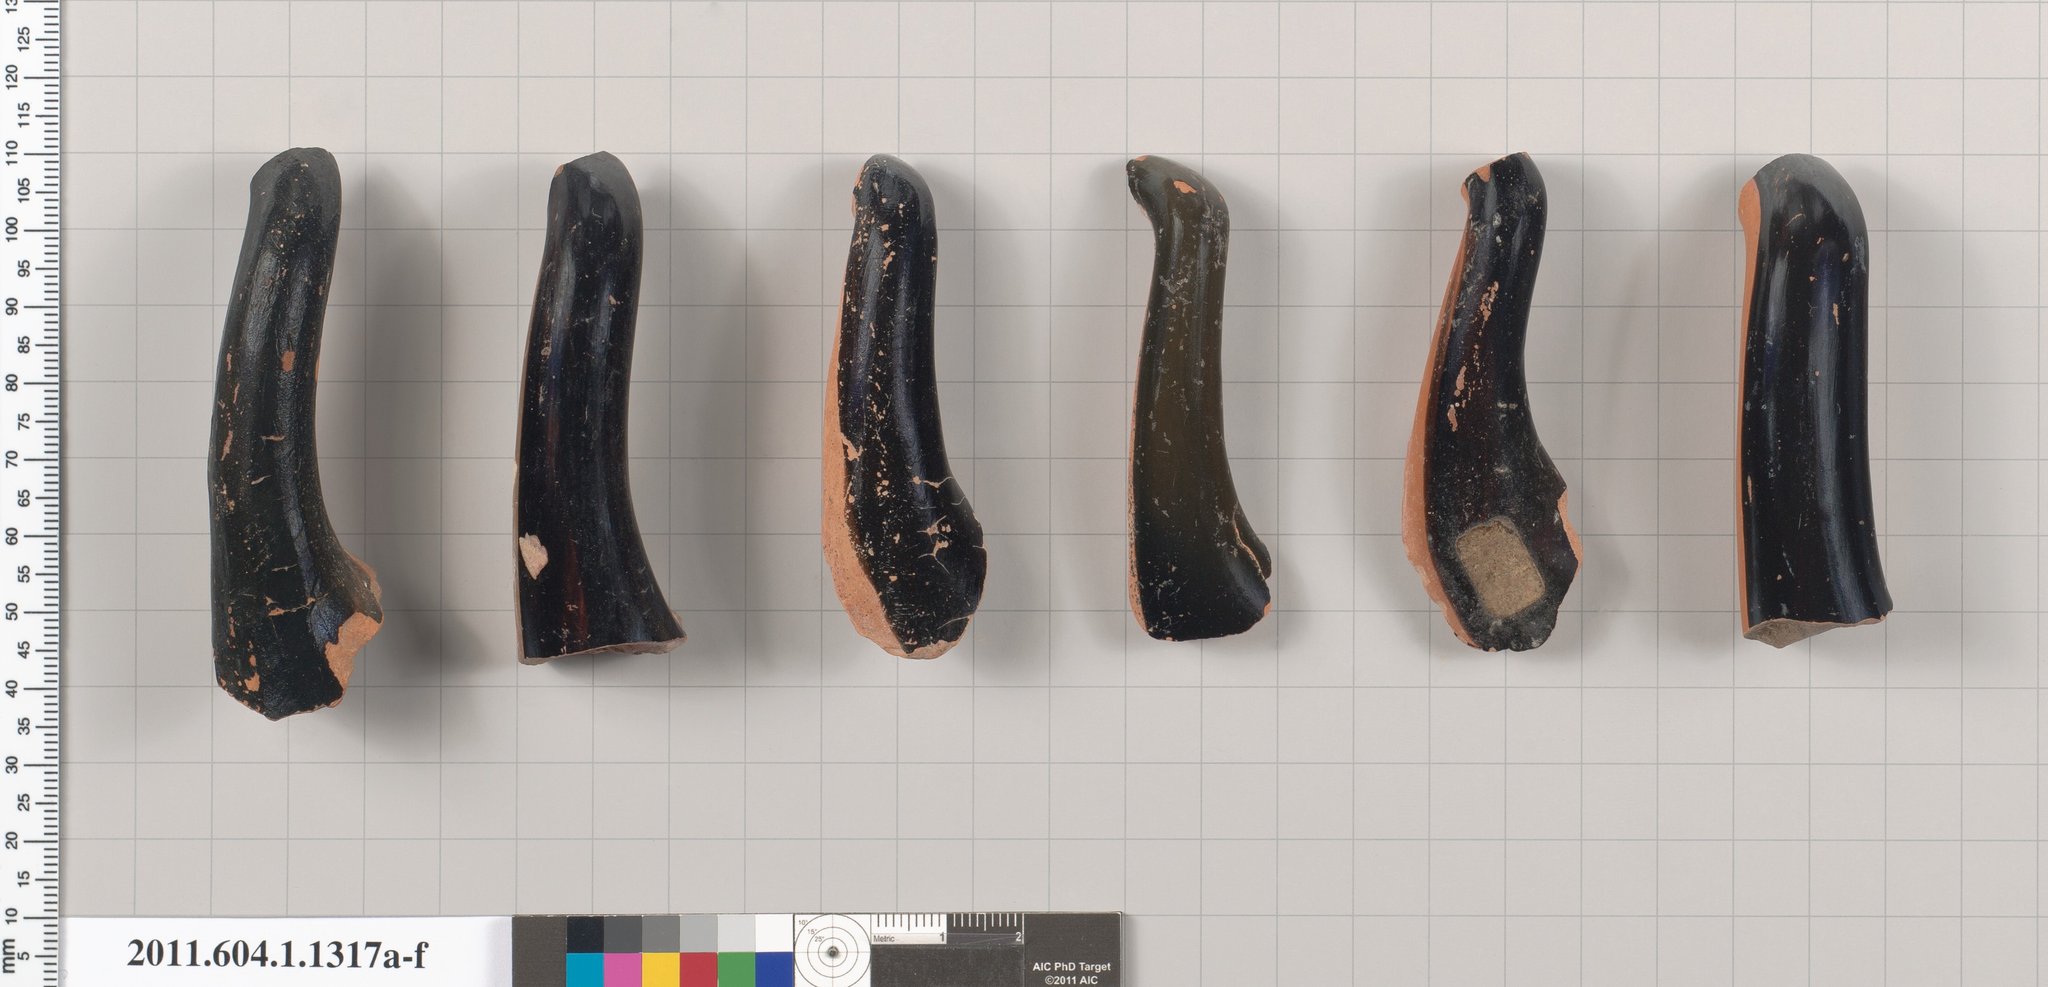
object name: kylix fragment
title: Terracotta fragments of kylikes (drinking cups)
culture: greek, attic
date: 500-401 BCE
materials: terracotta